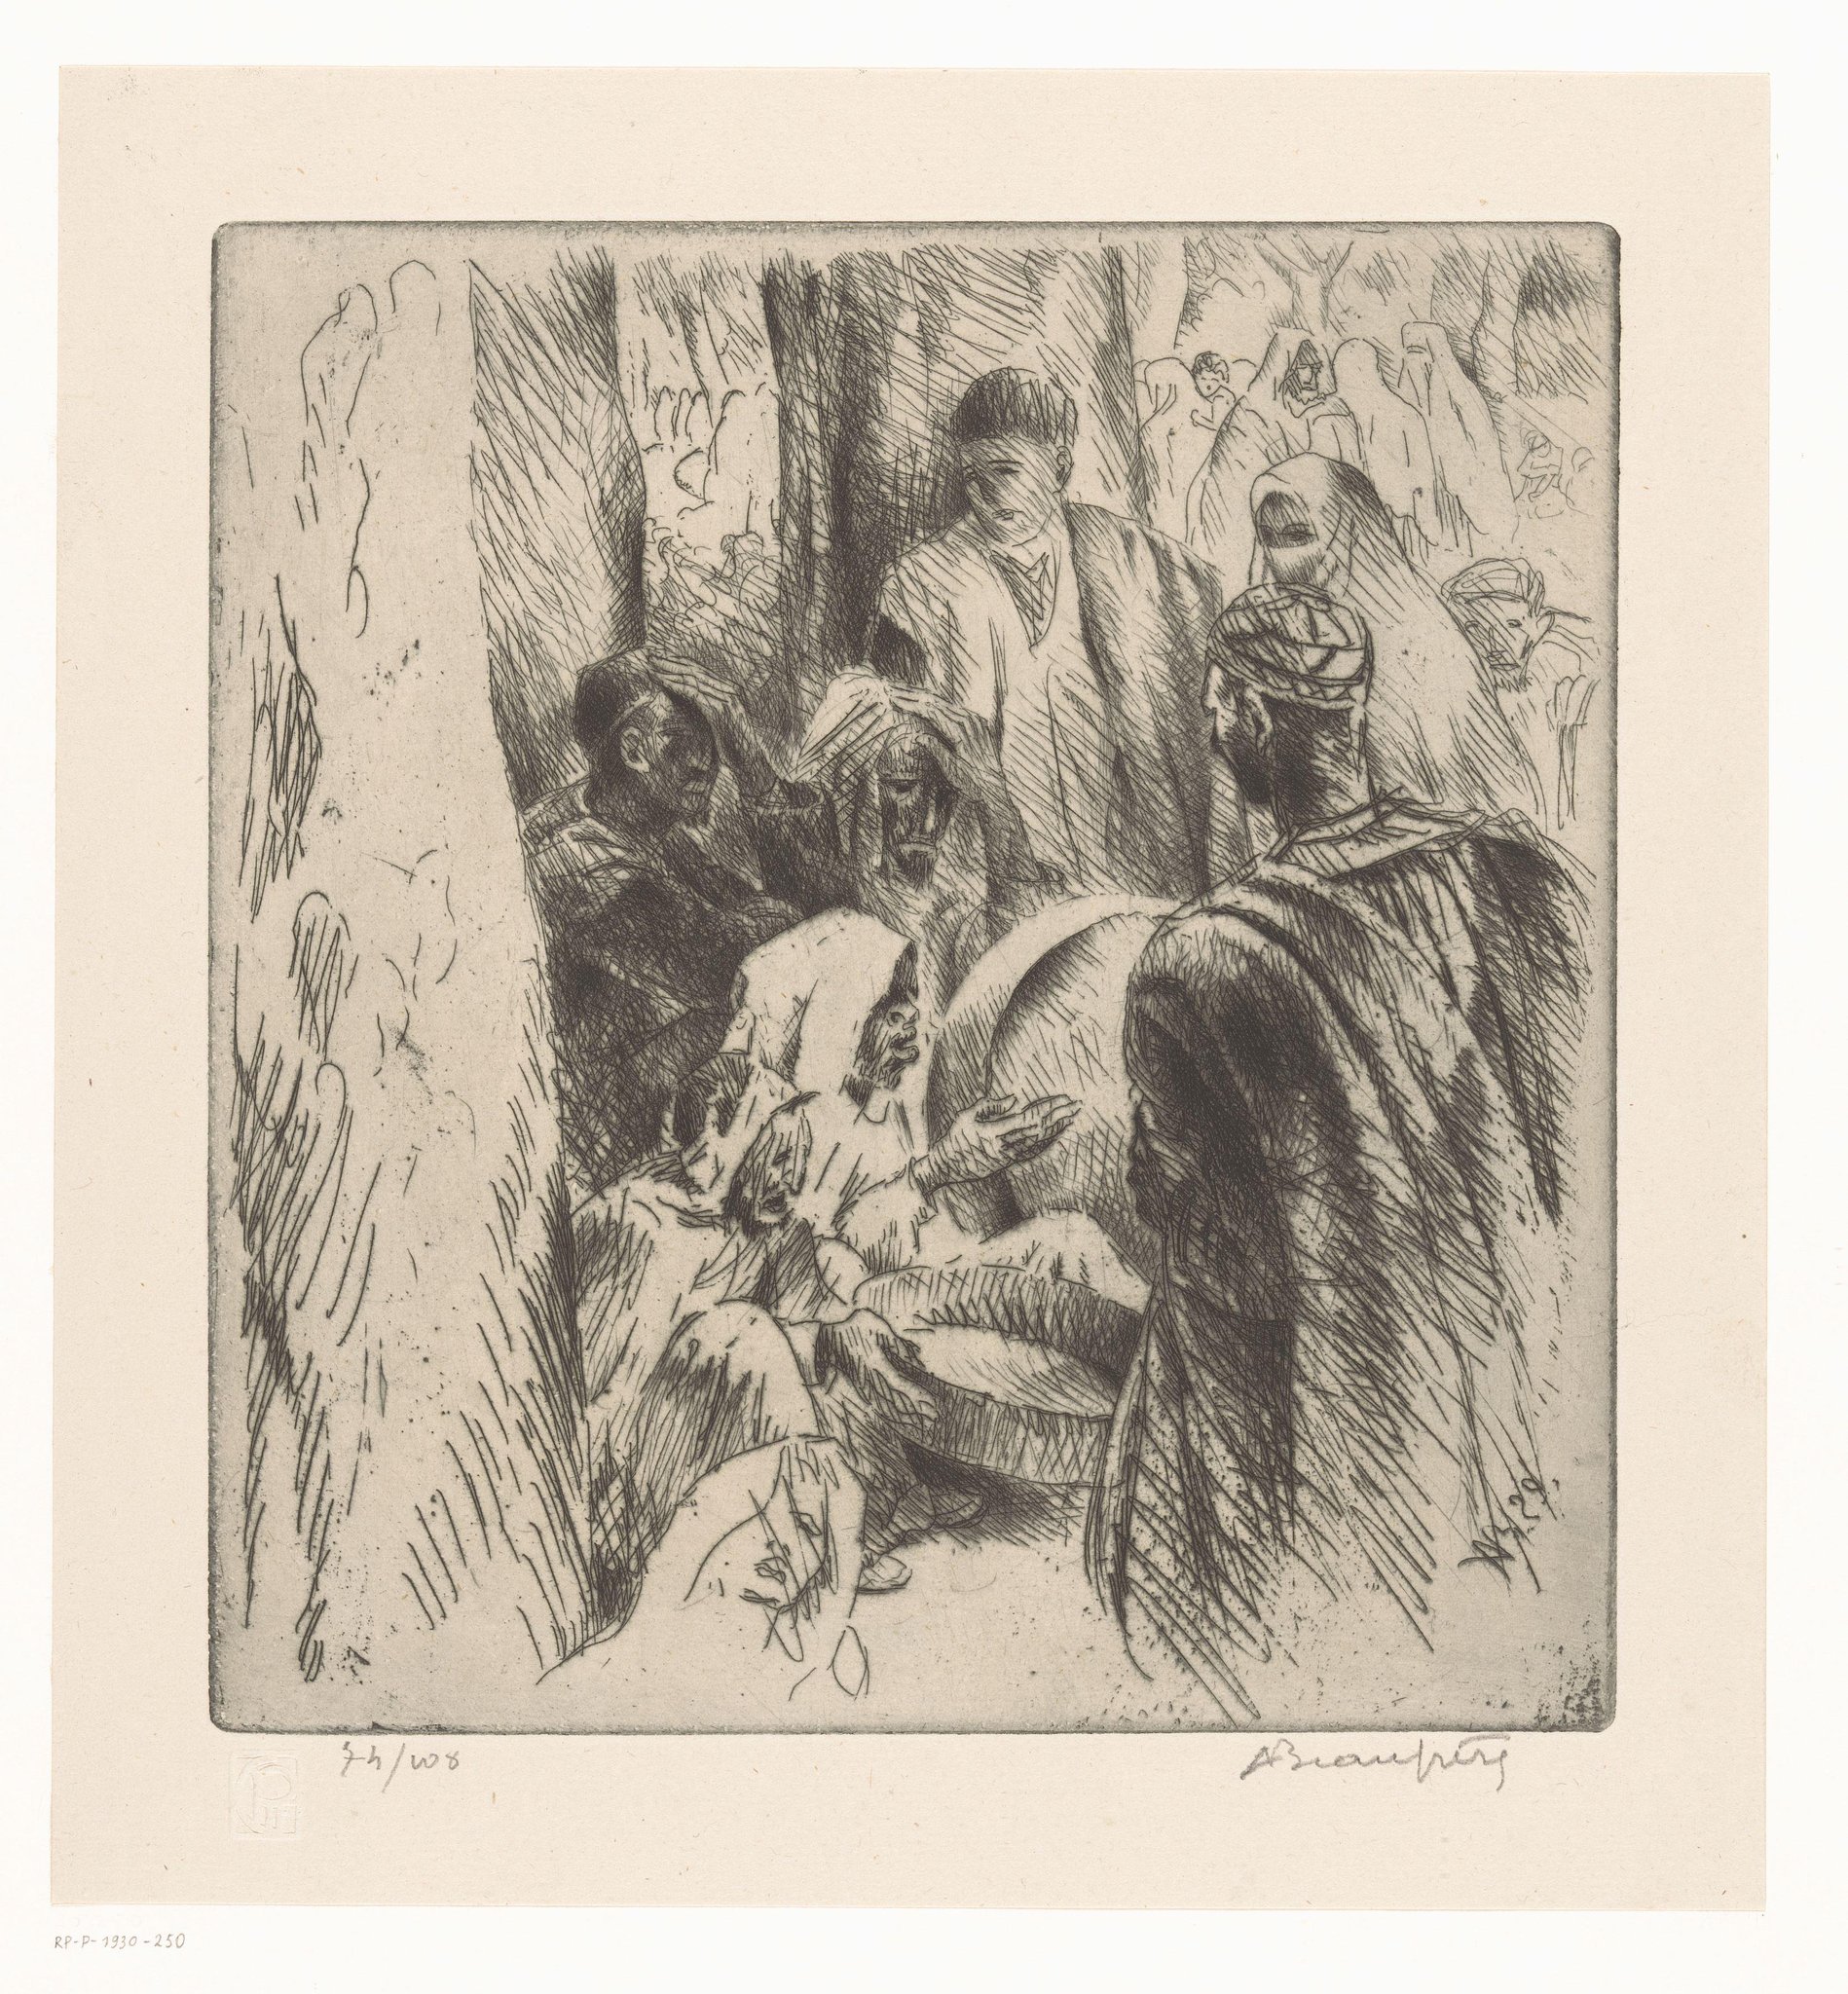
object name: print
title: Arabisch gezelschap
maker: adolphe marie timothée beaufrère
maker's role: print maker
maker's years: 1876-1960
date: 1929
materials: paper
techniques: drypoint, etching, intaglio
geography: france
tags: africans, forest, wood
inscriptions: inscription: ‘7h w8’, collector's mark: Lugt 1195a, collector's mark: Lugt 2228